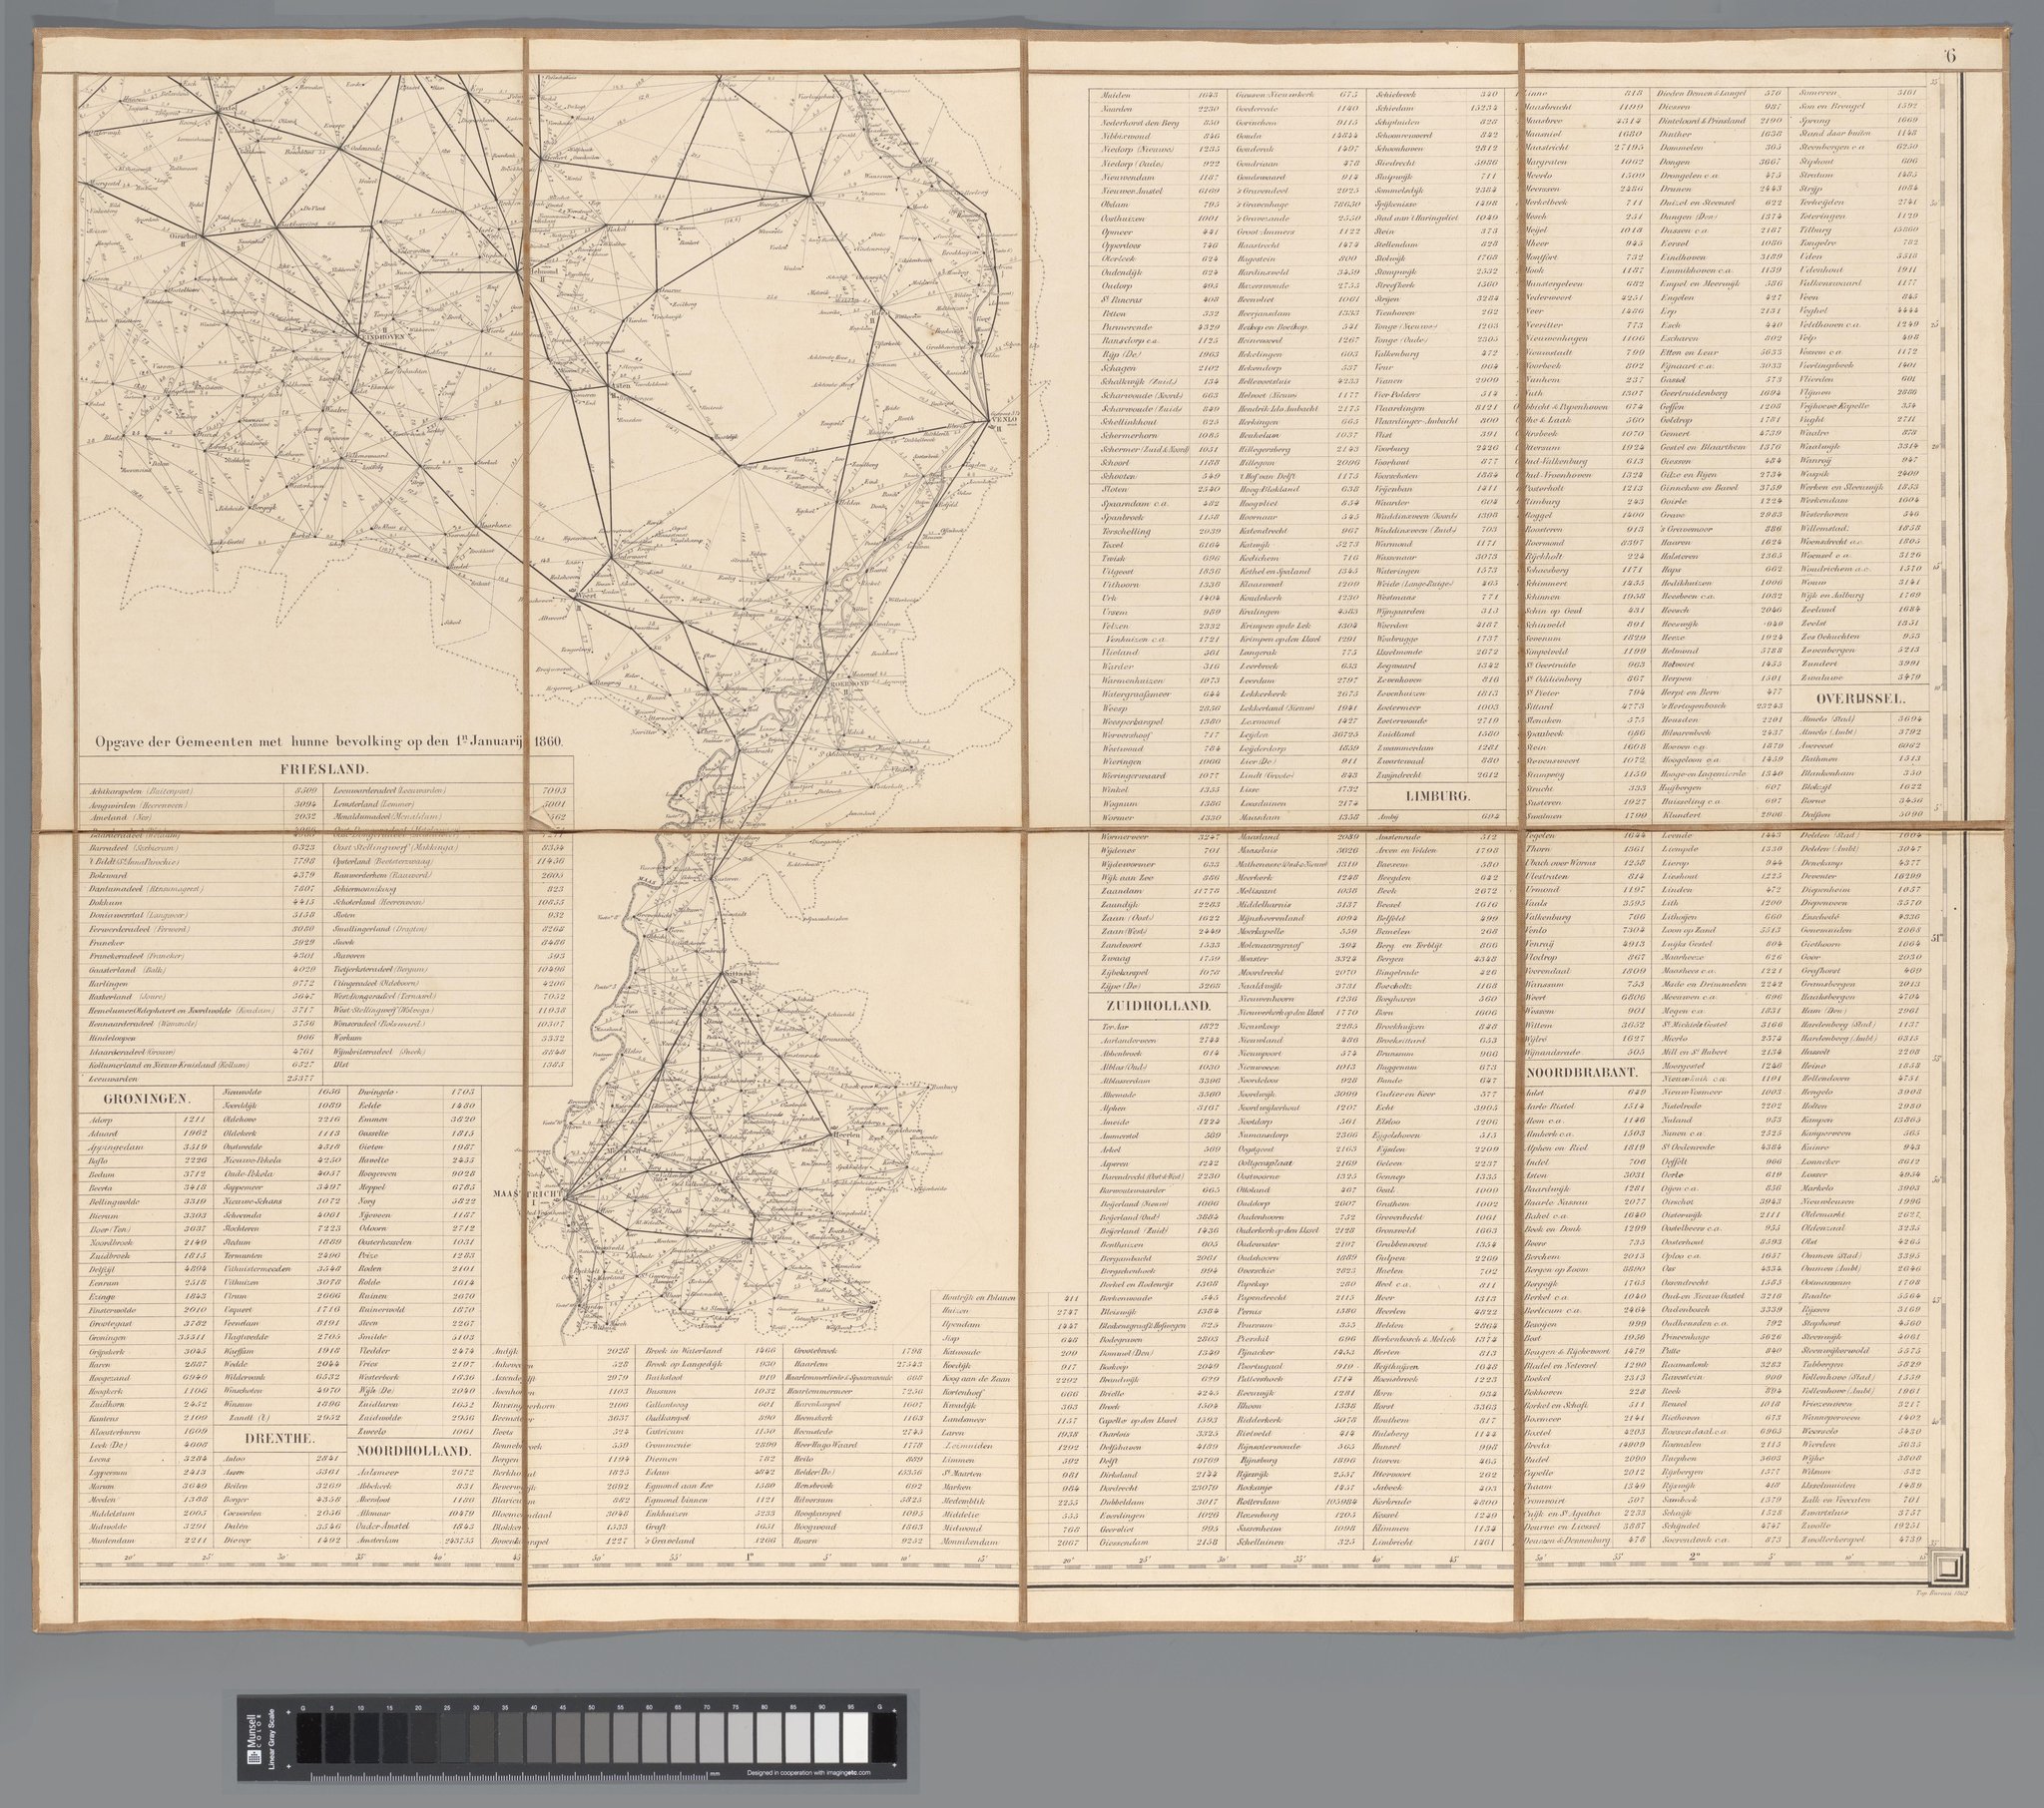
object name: map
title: Afstands-wijzer van het Koningrijk der Nederlanden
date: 1862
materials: linen, paper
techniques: lithograph, printing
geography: the hague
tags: netherlands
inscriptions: date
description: Eén van zes kaartenbladen met legenda (zie NG-934-1 t/m 6), op linnen geplakt, in kartonnen doos, buiten met zwart kunstleer beplakt en aan de binnenkant met groen-zwart ruitjespapier. Gedateerd; blad 3, l.b.: 1862.